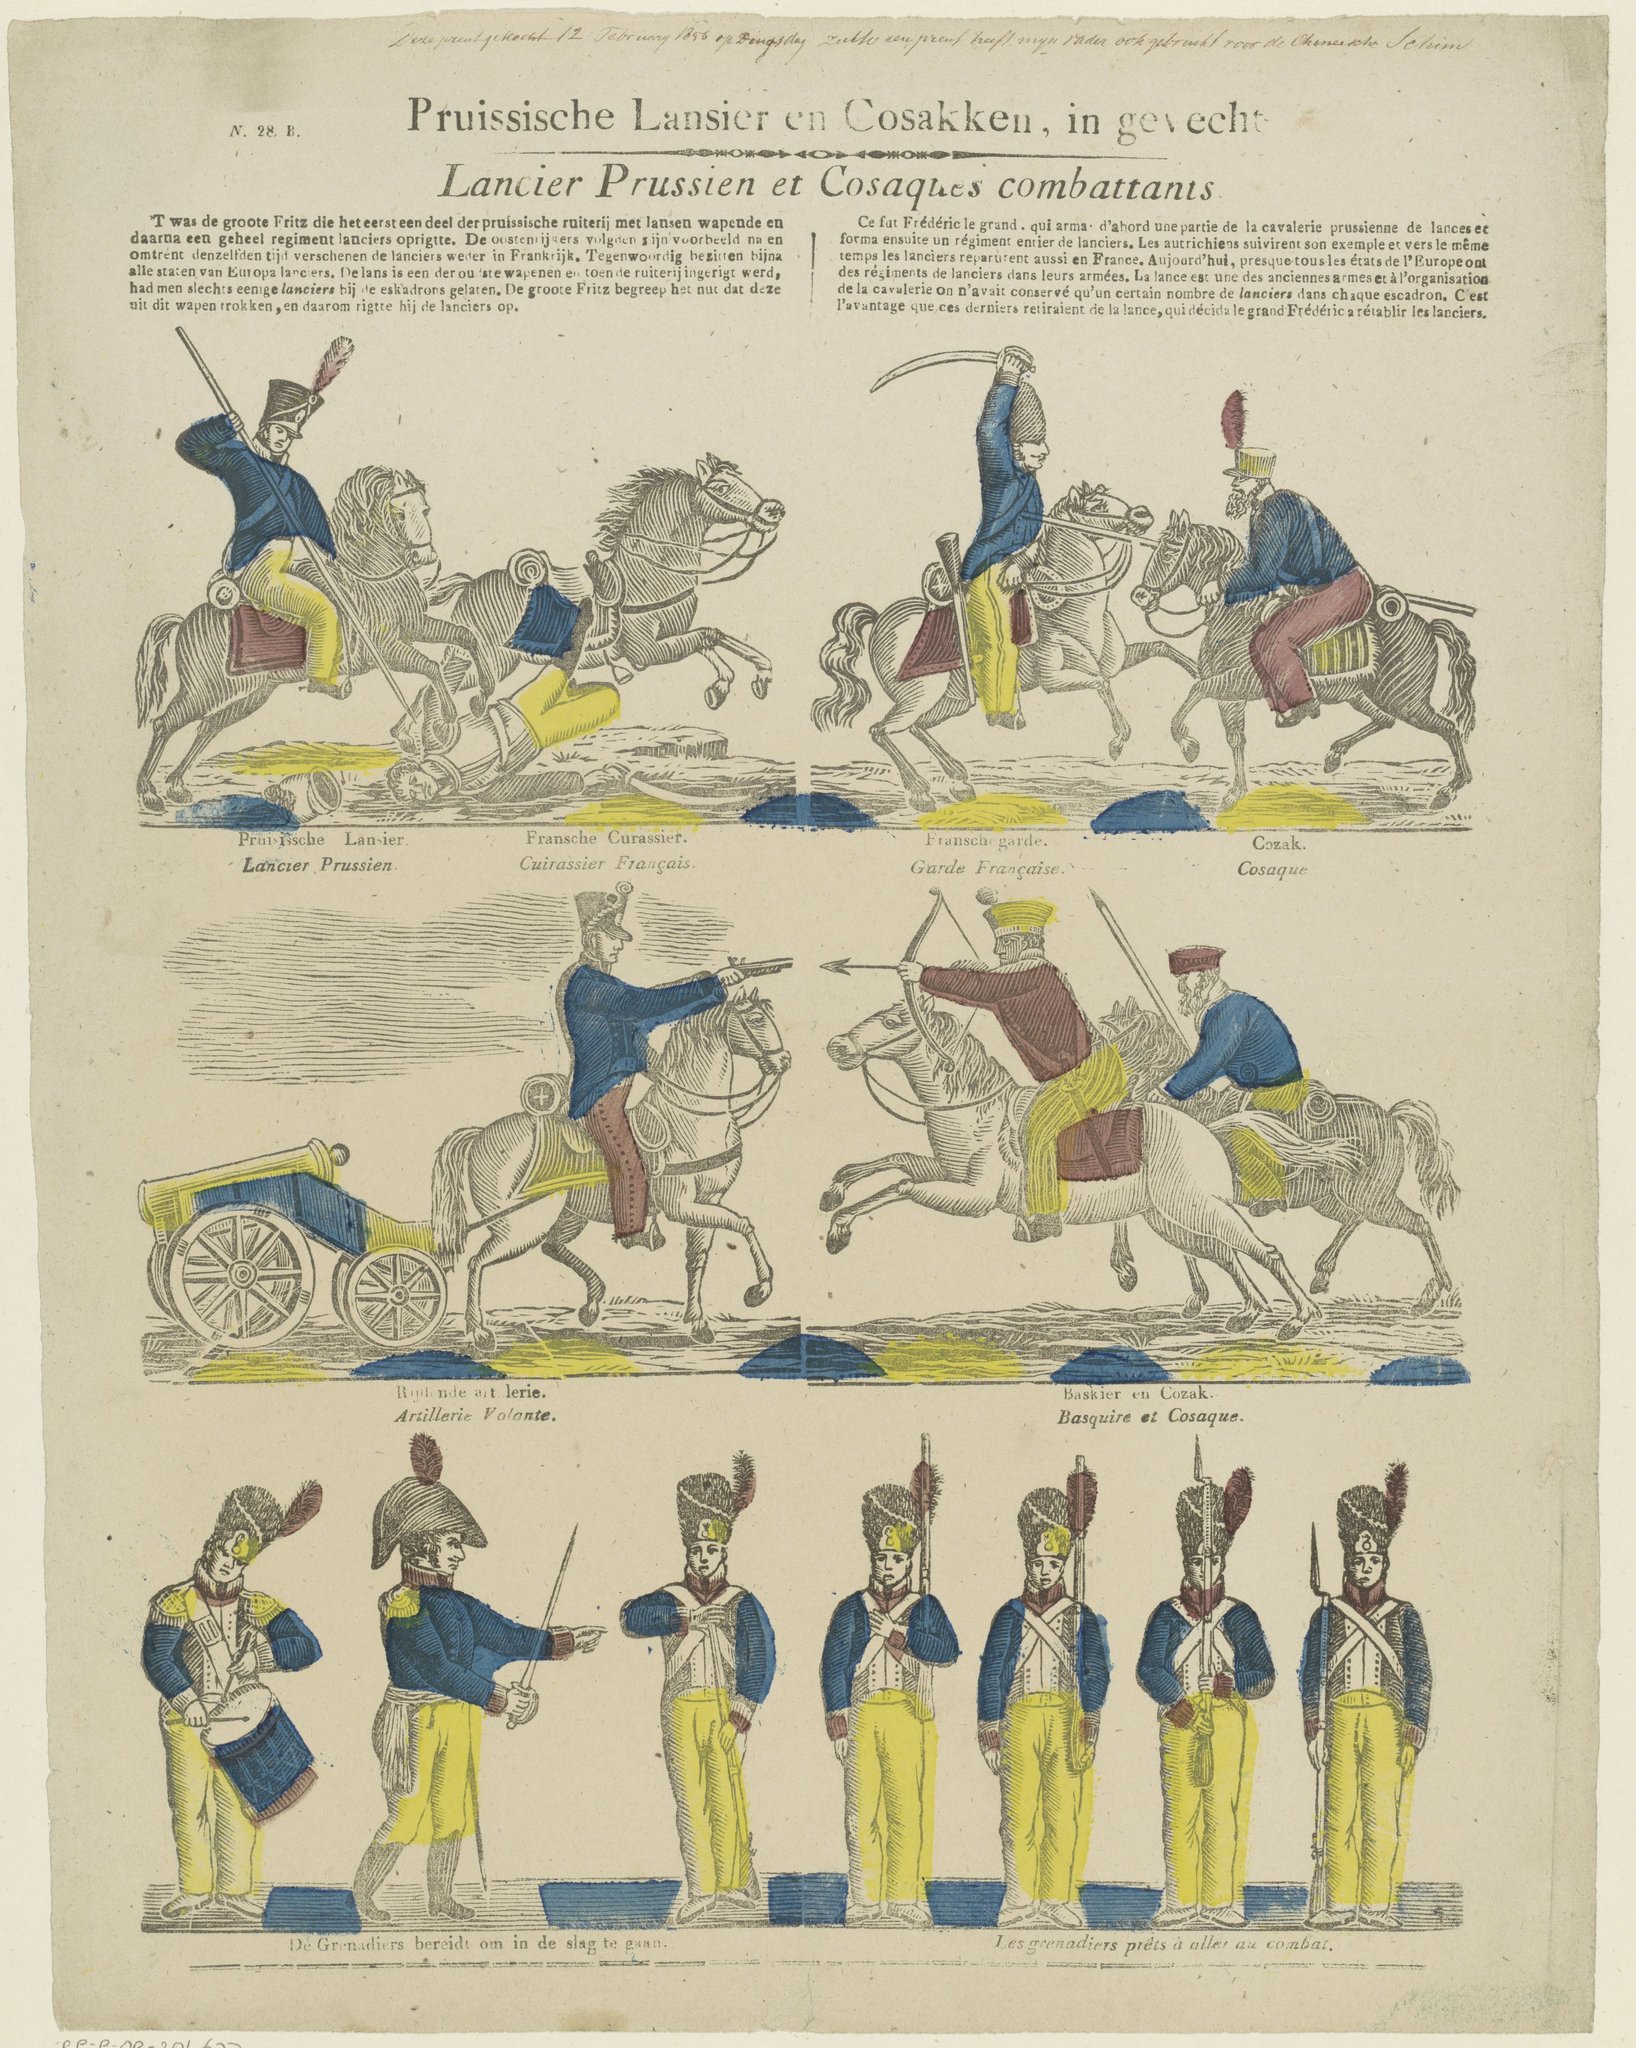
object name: popular print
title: Pruissische lansier en Cosakken, in gevecht / Lancier Prussien et Cosaques combattants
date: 1800-1833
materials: paper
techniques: colour, letterpress printing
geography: turnhout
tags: warfare; military affairs (+ cavalry, horsemen), the soldier; the soldier's life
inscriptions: inscription: ‘Deze prent gekocht 12 February 1856 op Dingsdag zulk een prent heeft mijn vader ook gebruikt voor de Chineesche schim.’, collector's mark: Lugt 2760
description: Blad met 3 horizontale rijen met voorstellingen van militairen te voet, met wapens en te paard. Onder elke voorstelling een onderschrift in het Nederlands en in het Frans, zesregelig bovenschrift in het Nederlands en in het Frans in twee kolommen. Genummerd linksboven: N. 28 B.